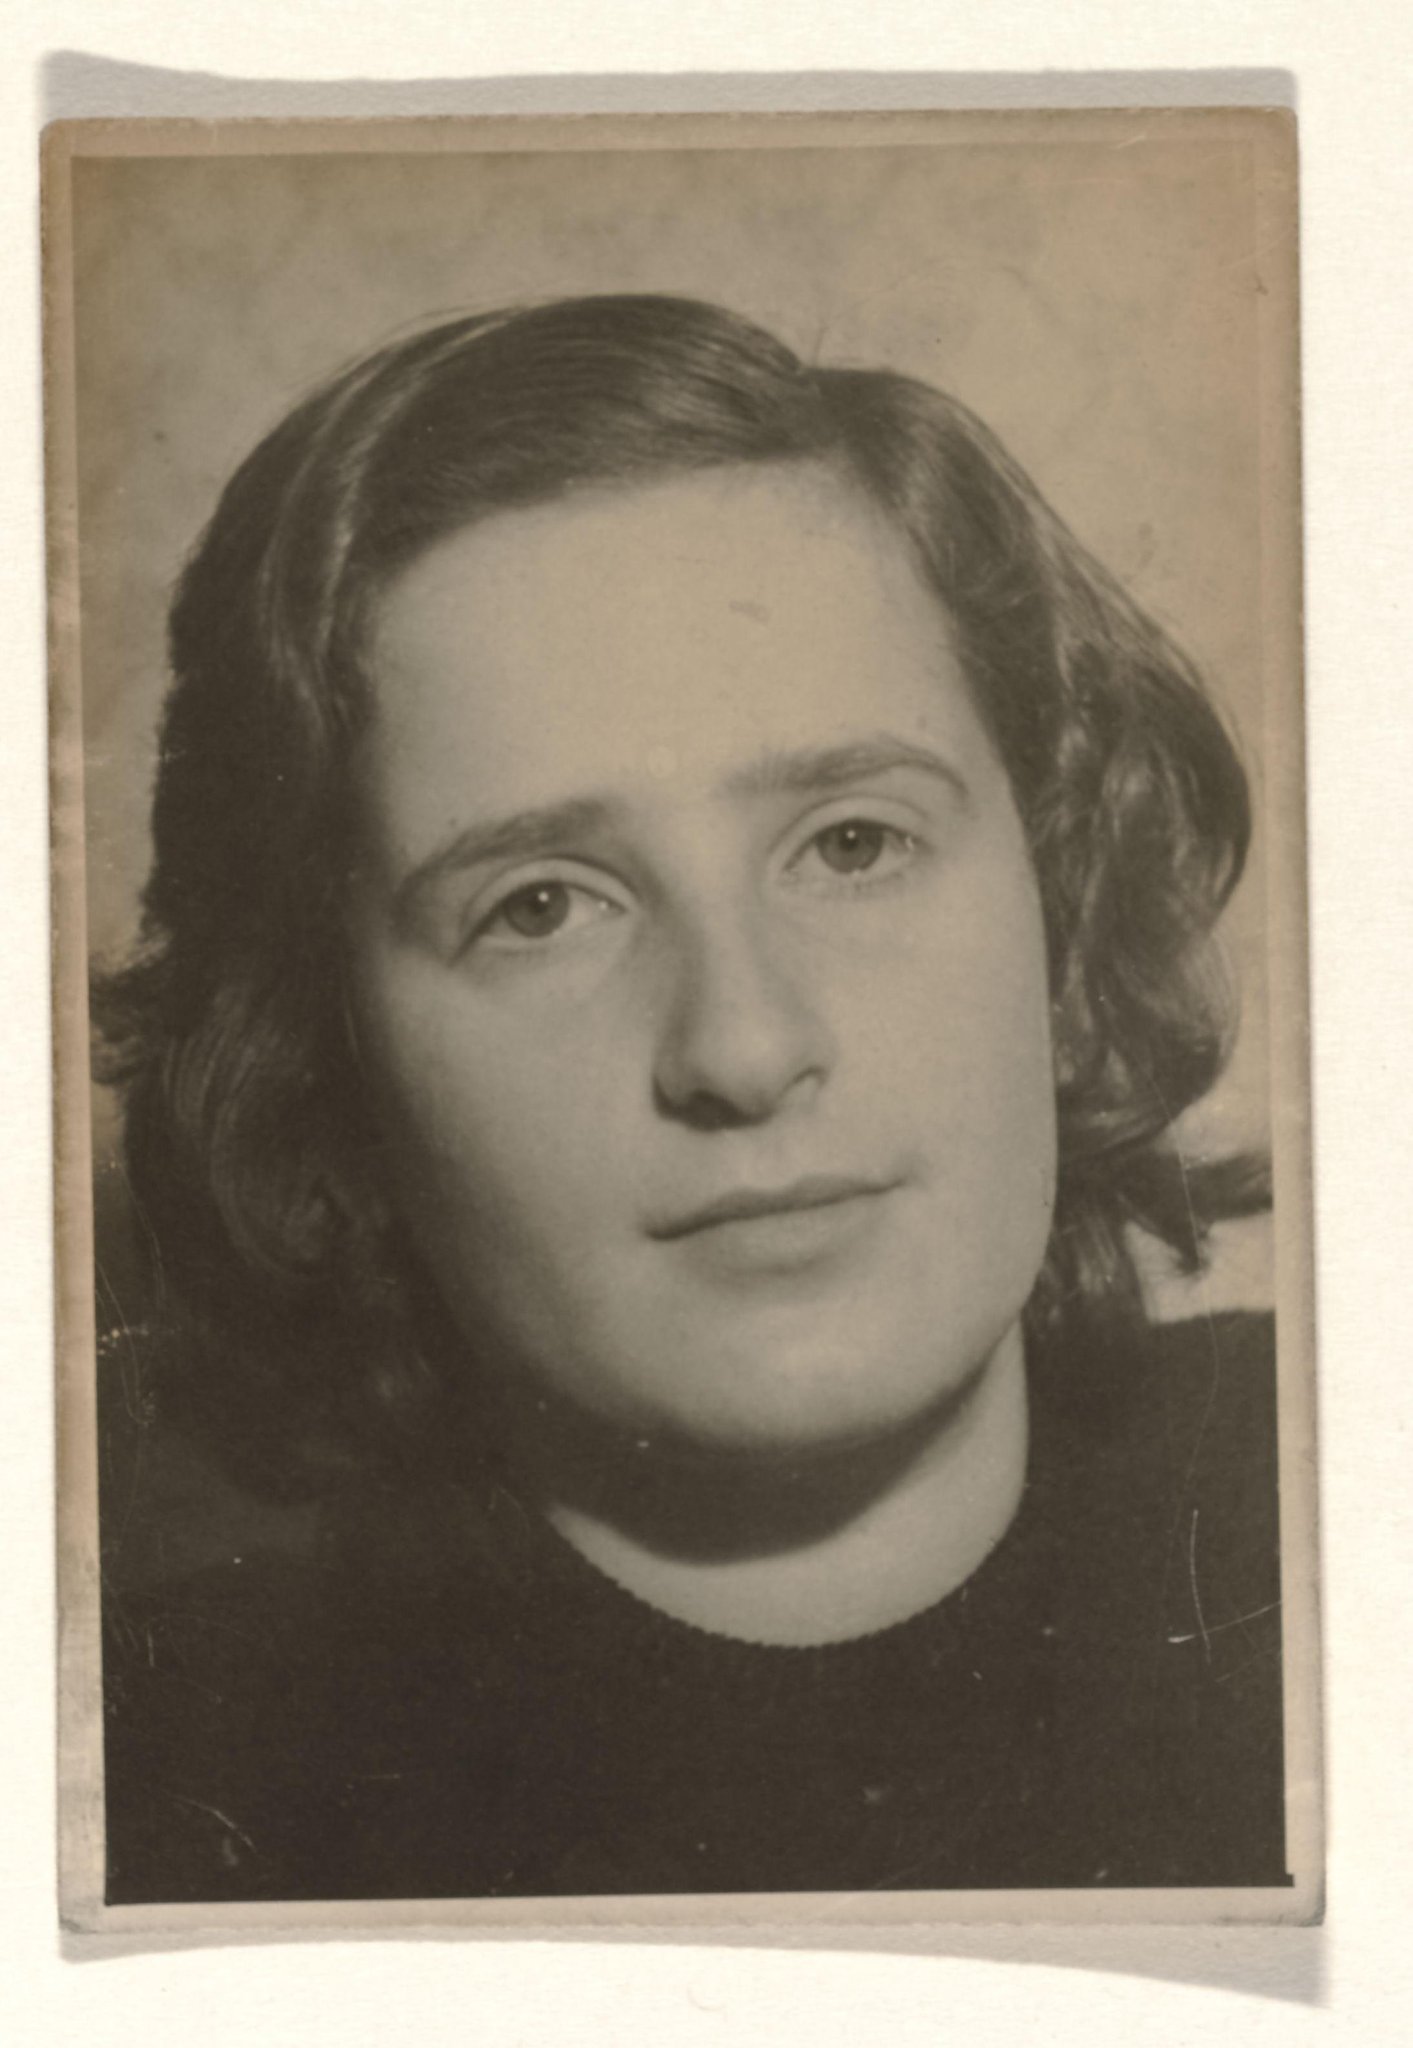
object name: photograph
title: Photographs from the Estate of Isabel Wachenheimer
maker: Anonymous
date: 1945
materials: photographic support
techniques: gelatin silver print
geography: davos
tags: isabel wachenheimer-elon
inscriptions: inscription: ‘Für meinen lieben K.Z. Häftling No 794 zur bleibenden Erin- nerung an unsere ge- meinsamen schweren stun- den und an Deinen alten K.Z. Hätling No 918 25.9.1945.’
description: Isabel Wachenheimer still signed with her concentration camp number, ‘K.Z. häftling No 918’ three months after she was liberated. Just see the inscription on the back of a portrait photograph of her taken on 25 September 1945. Isabel was a broken person after the war. She slowly recuperated from a fractured vertebra in Davos (Switzerland). In November 1946 Isabel married Leo Blumensohn, a fellow victim she met in the Westerbork transit camp.